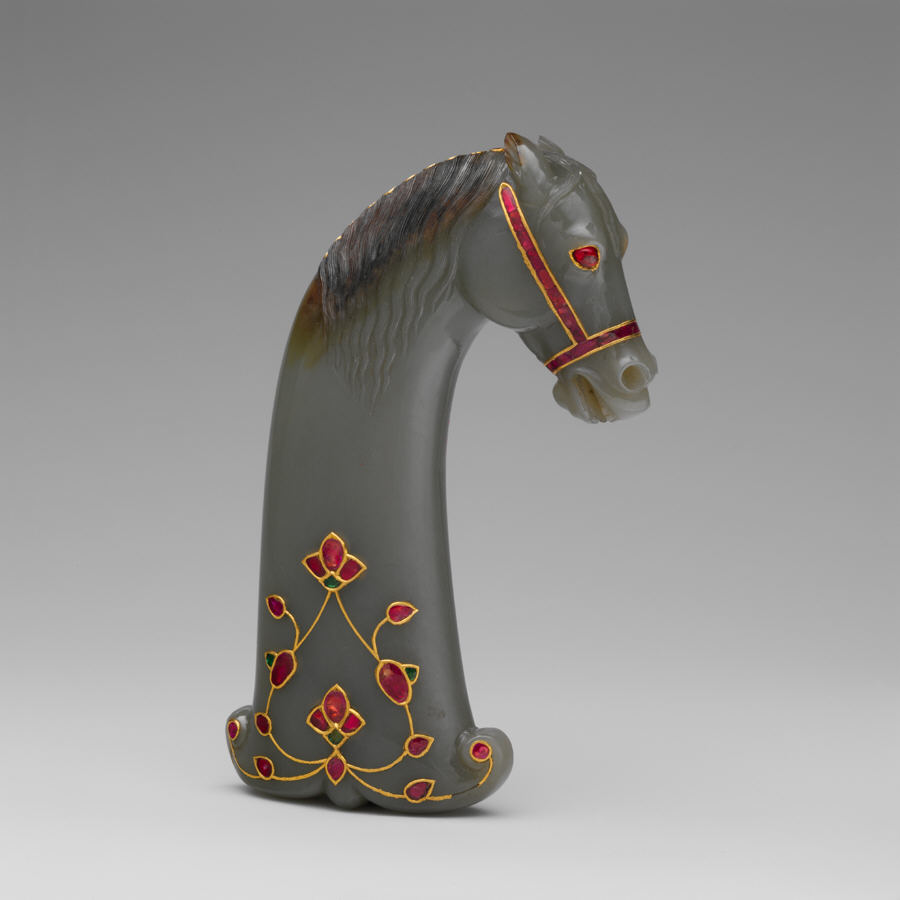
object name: sword handle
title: Sword handle in the shape of a horse’s head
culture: indian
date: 1701-1900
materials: gold, jade, stone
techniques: inlay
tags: hilts,horses